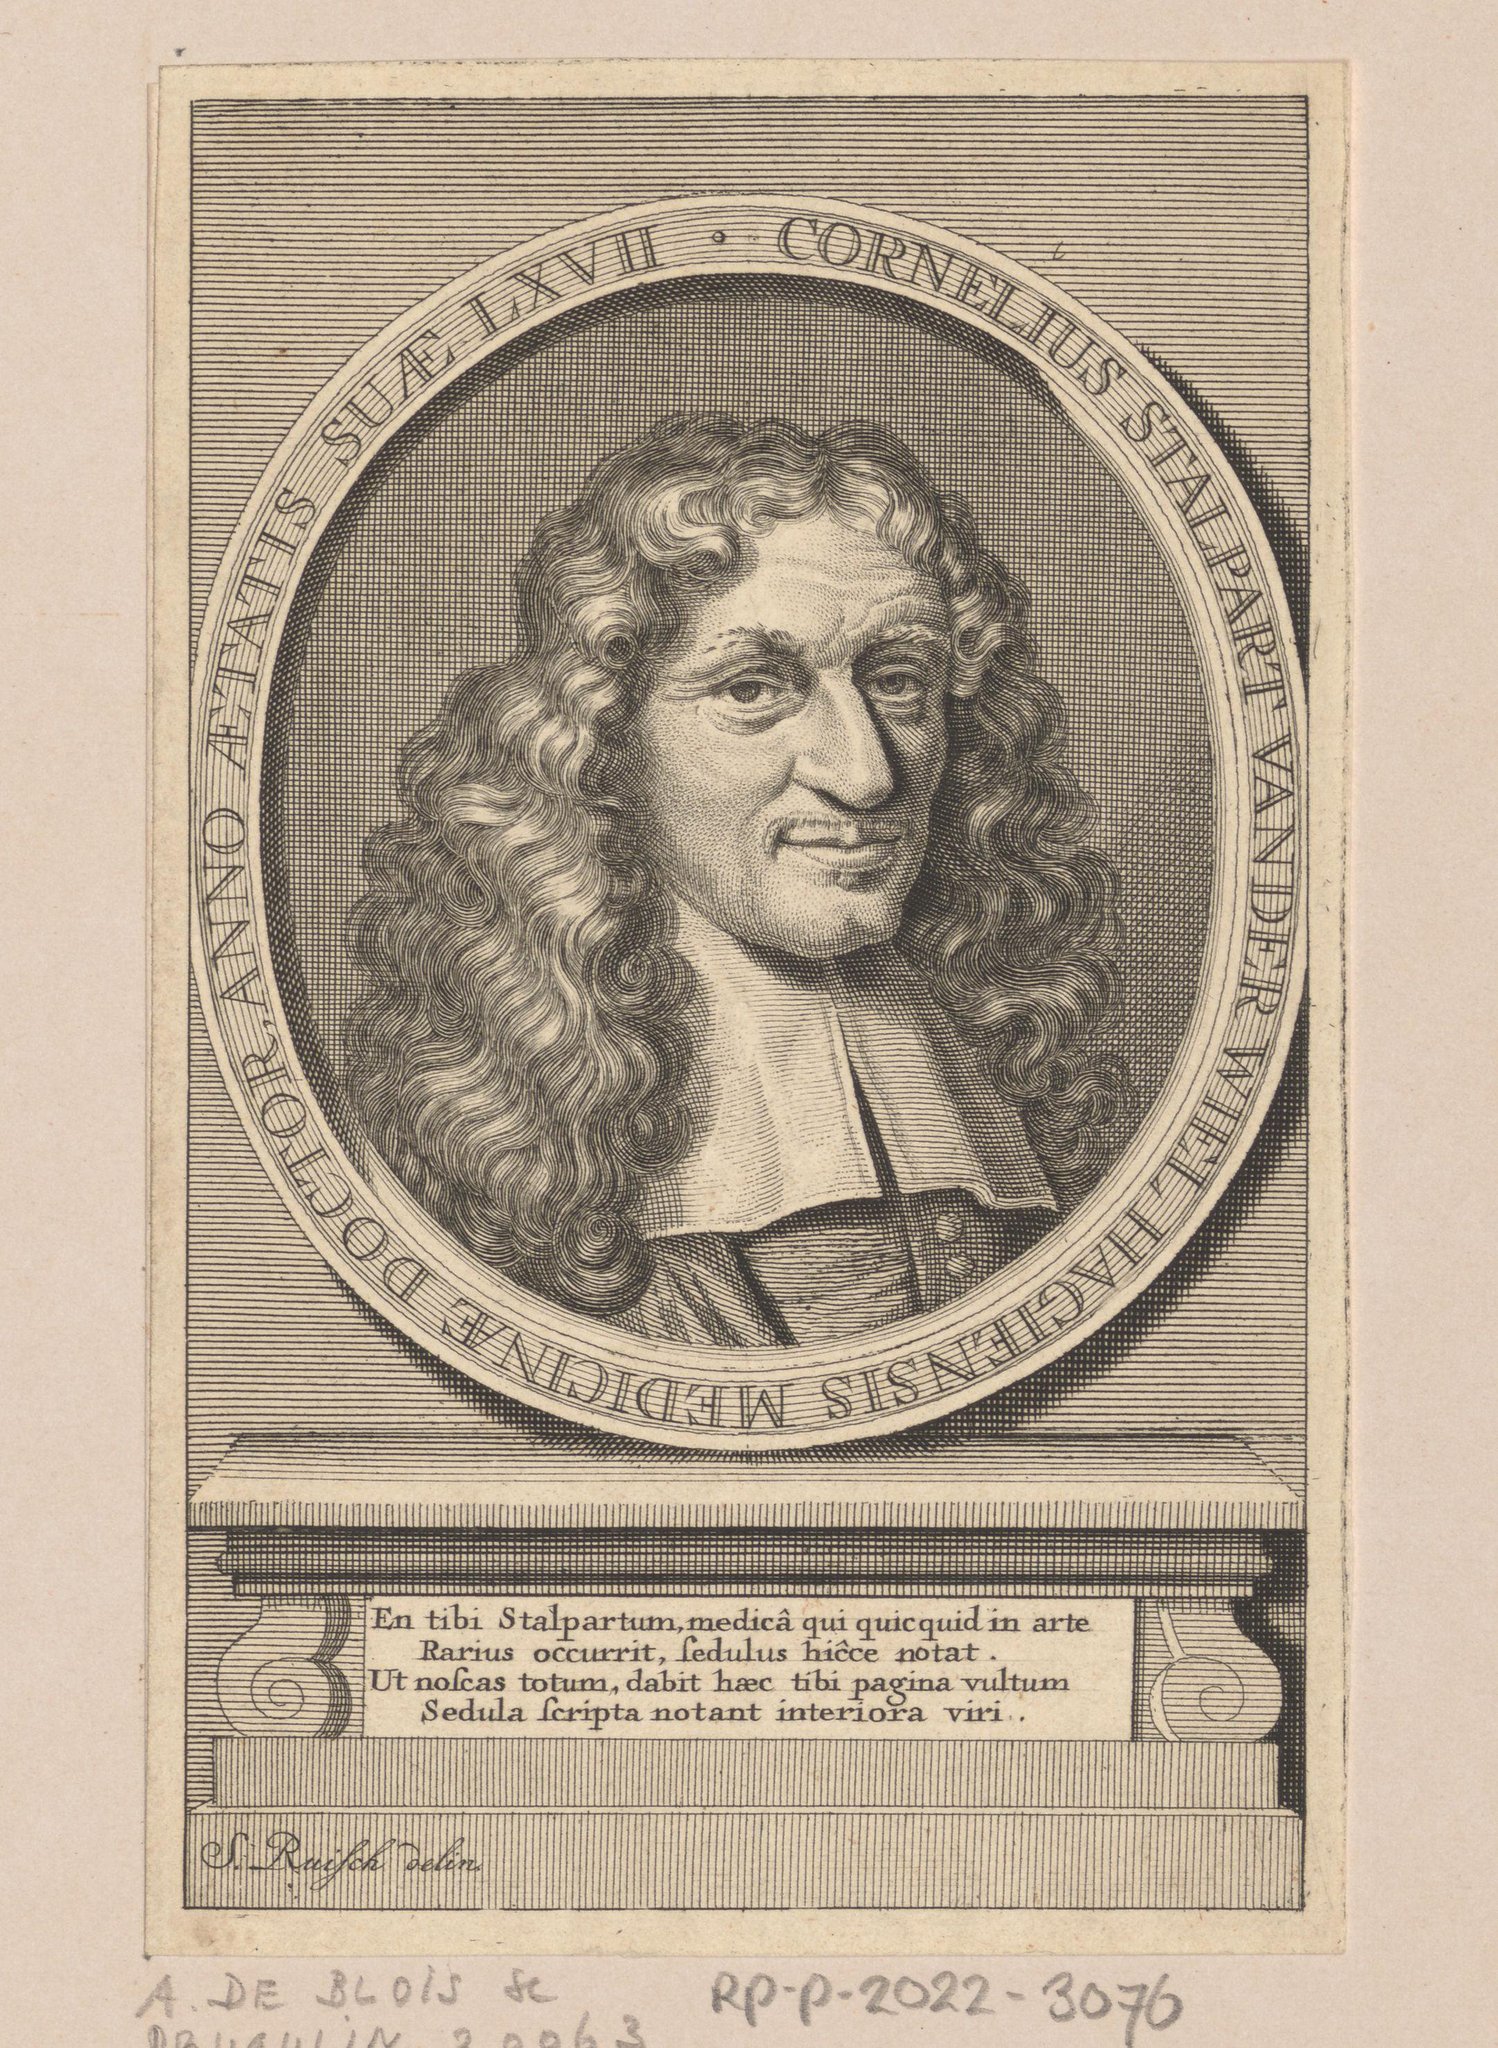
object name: print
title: Portret van Cornelis Stalpart vander Wiel op 67-jarige leeftijd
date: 1682-1699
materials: paper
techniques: engraving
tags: the hague, historical persons, physician, doctor (+ portrait of scholar, scientist)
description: Met vierregelig onderschrift in het Latijn en tekst in het Latijn rondom het portret.